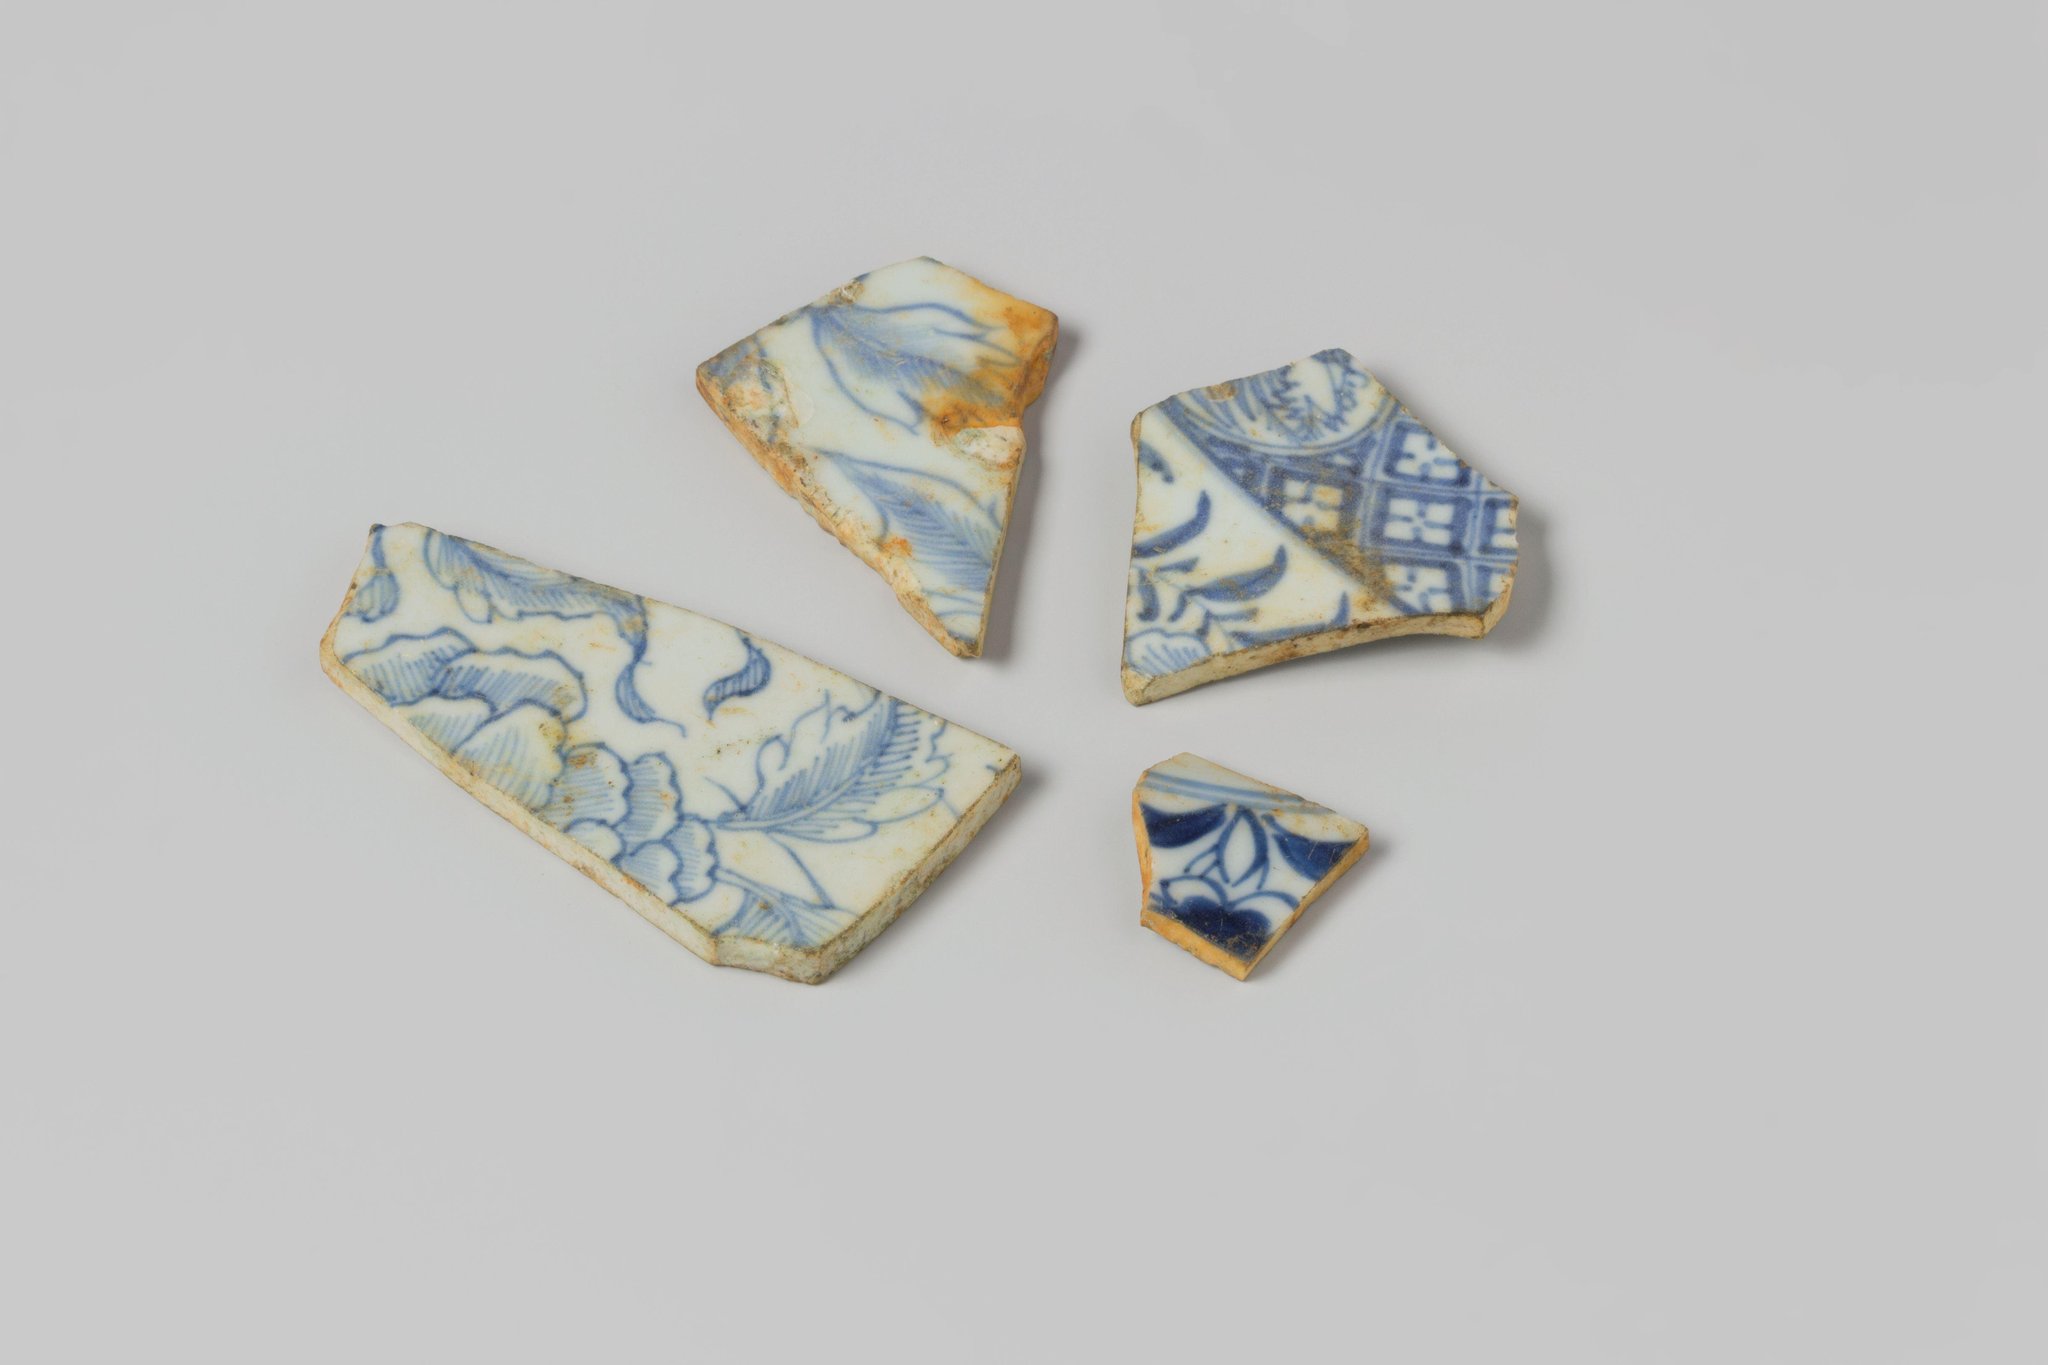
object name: sherd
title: Scherven van borden uit het wrak van de Oost-Indiëvaarder Hollandia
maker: Anonymous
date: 1700-1743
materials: earthenware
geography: netherlands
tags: verenigde oostindische compagnie, hollandia (schip), annet